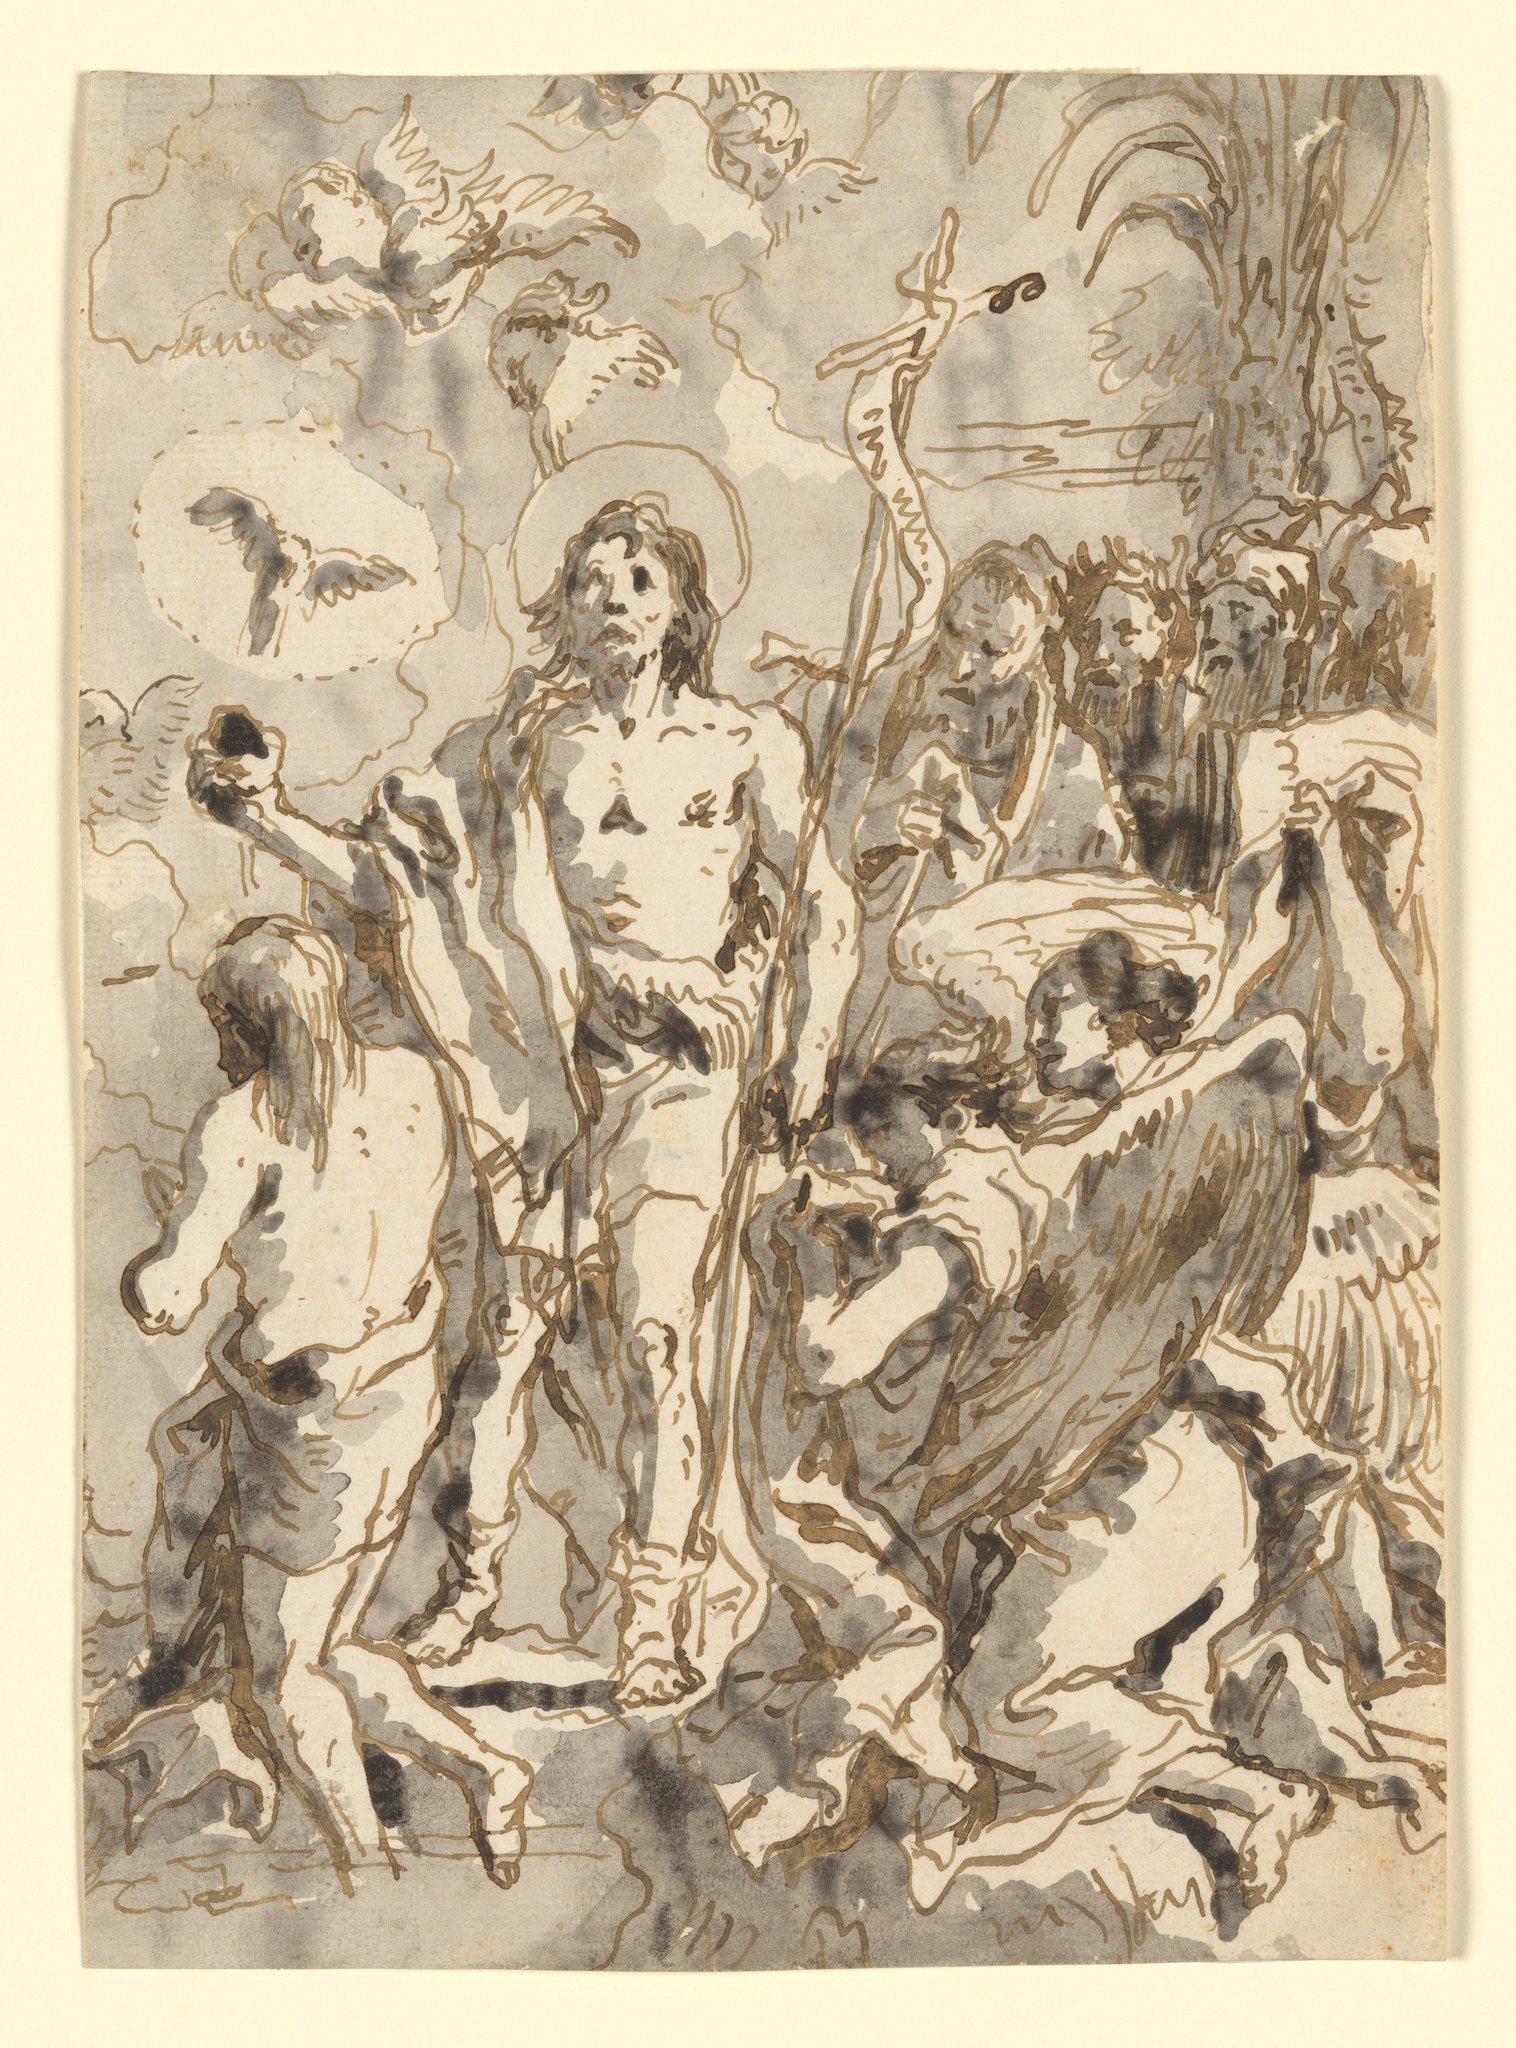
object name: drawing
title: The Baptism of Christ (with Christ Half-Kneeling at Left, His Back Turned, and the Baptist Full-Faced at Center, Looking Up)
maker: giovanni domenico tiepolo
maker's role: artist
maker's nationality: italian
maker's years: 1727-1804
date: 1770-1790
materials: ink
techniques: pen, wash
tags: men,angels,baptism of christ